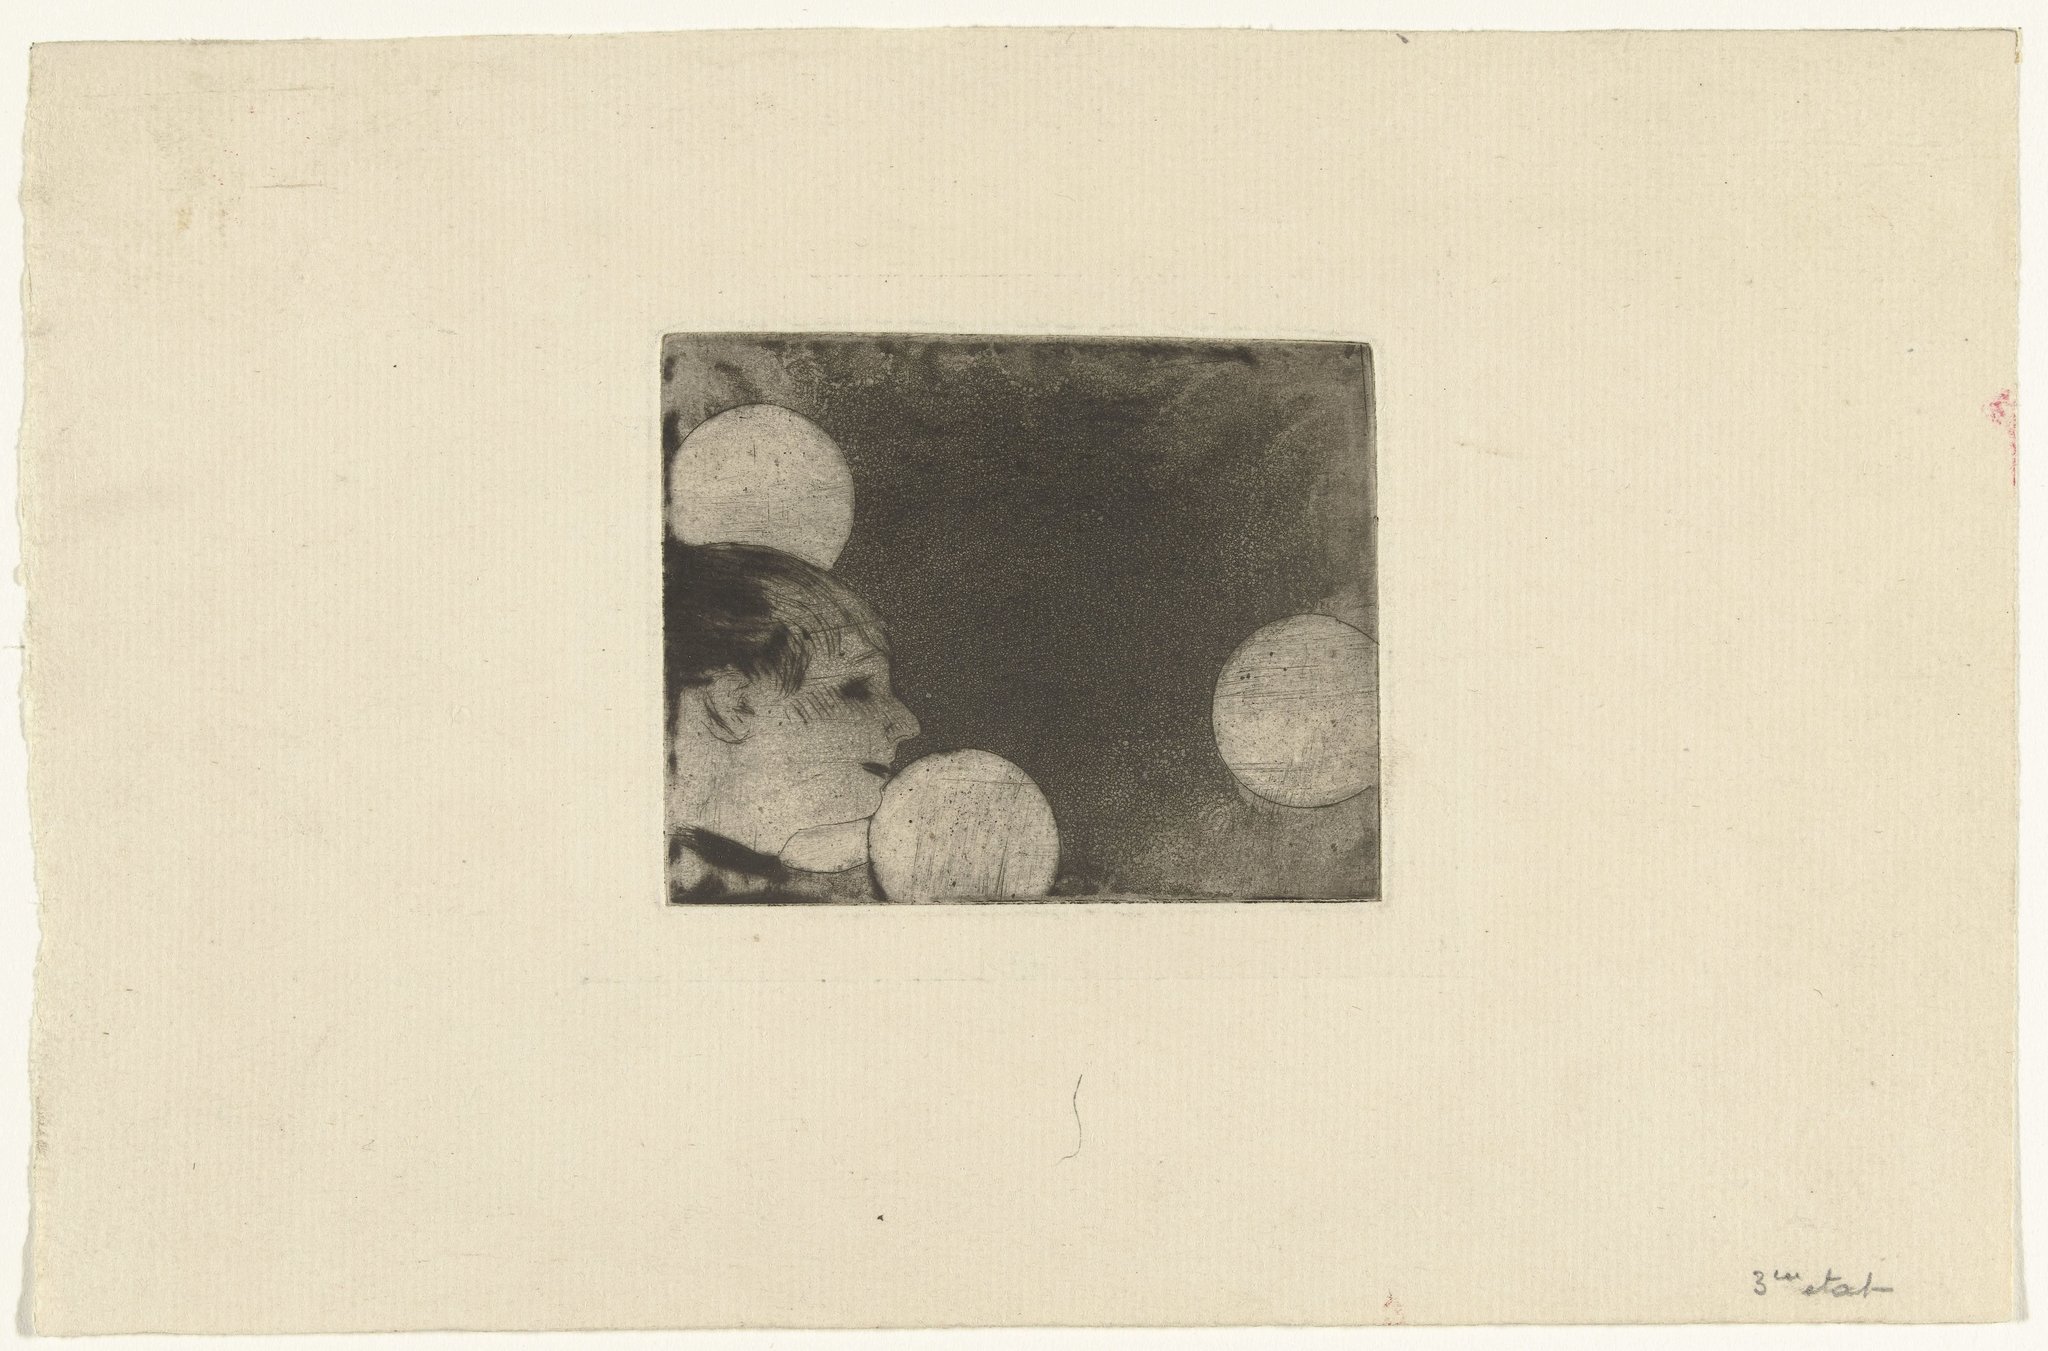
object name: print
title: Profil de Chanteuse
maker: edgar degas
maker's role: draughtsman, painter, print maker, sculptor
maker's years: 1834-1917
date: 1877-1878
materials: paper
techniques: aquatint, drypoint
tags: singer without accompaniment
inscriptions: collector's mark: Lugt 2228, workshop stamp: Lugt 657, collector's mark: Lugt 2760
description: Hoofd van een zangeres en profil in een donkere omgeving terwijl haar gezicht wordt verlicht door licht van het podium onder haar. Op de achtergrond in het duister staan vier bollen van de gaslampen op straat. Het hoofd van de vrouw wordt links afgesneden door de rand van de voorstelling.